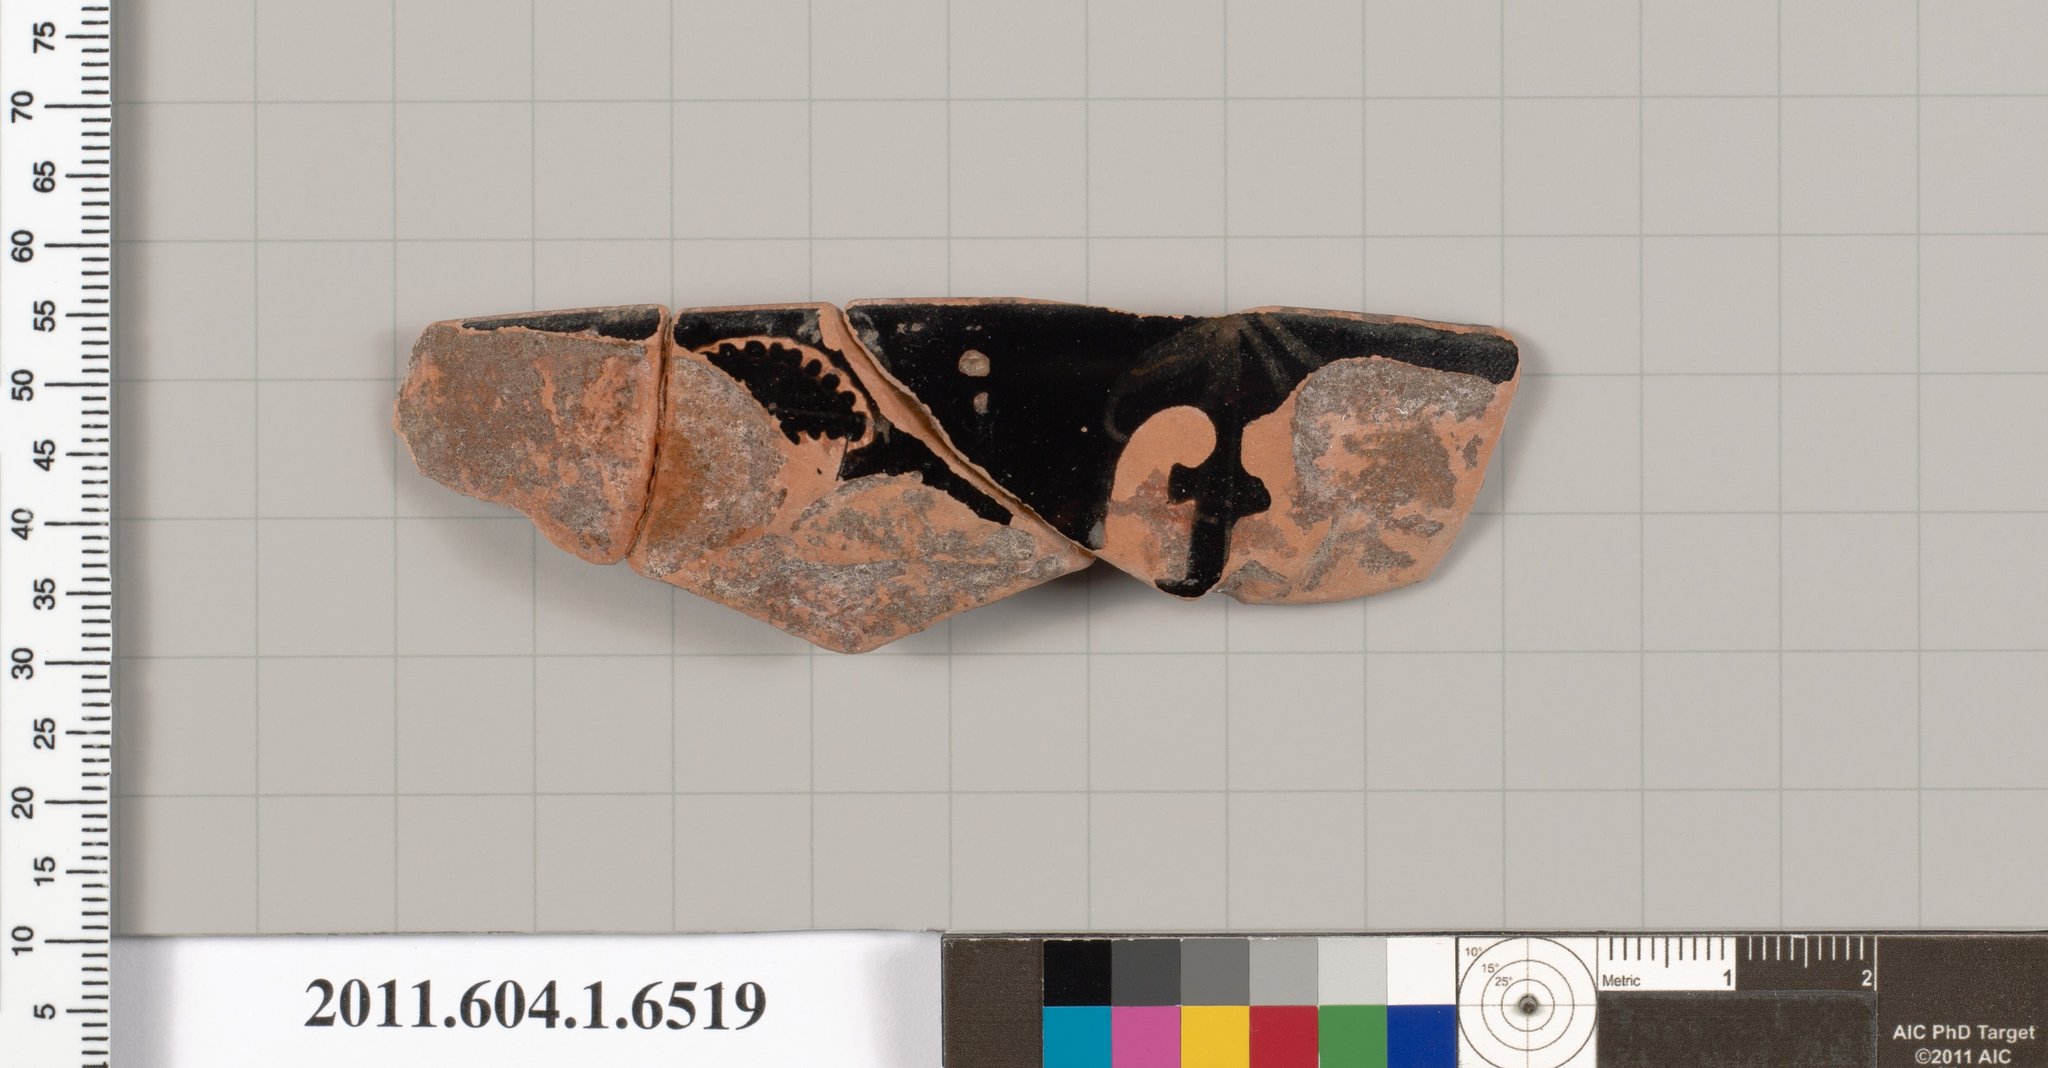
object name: kylix fragment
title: Terracotta rim fragment of a kylix (drinking cup)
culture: greek, attic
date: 490-480 BCE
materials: terracotta